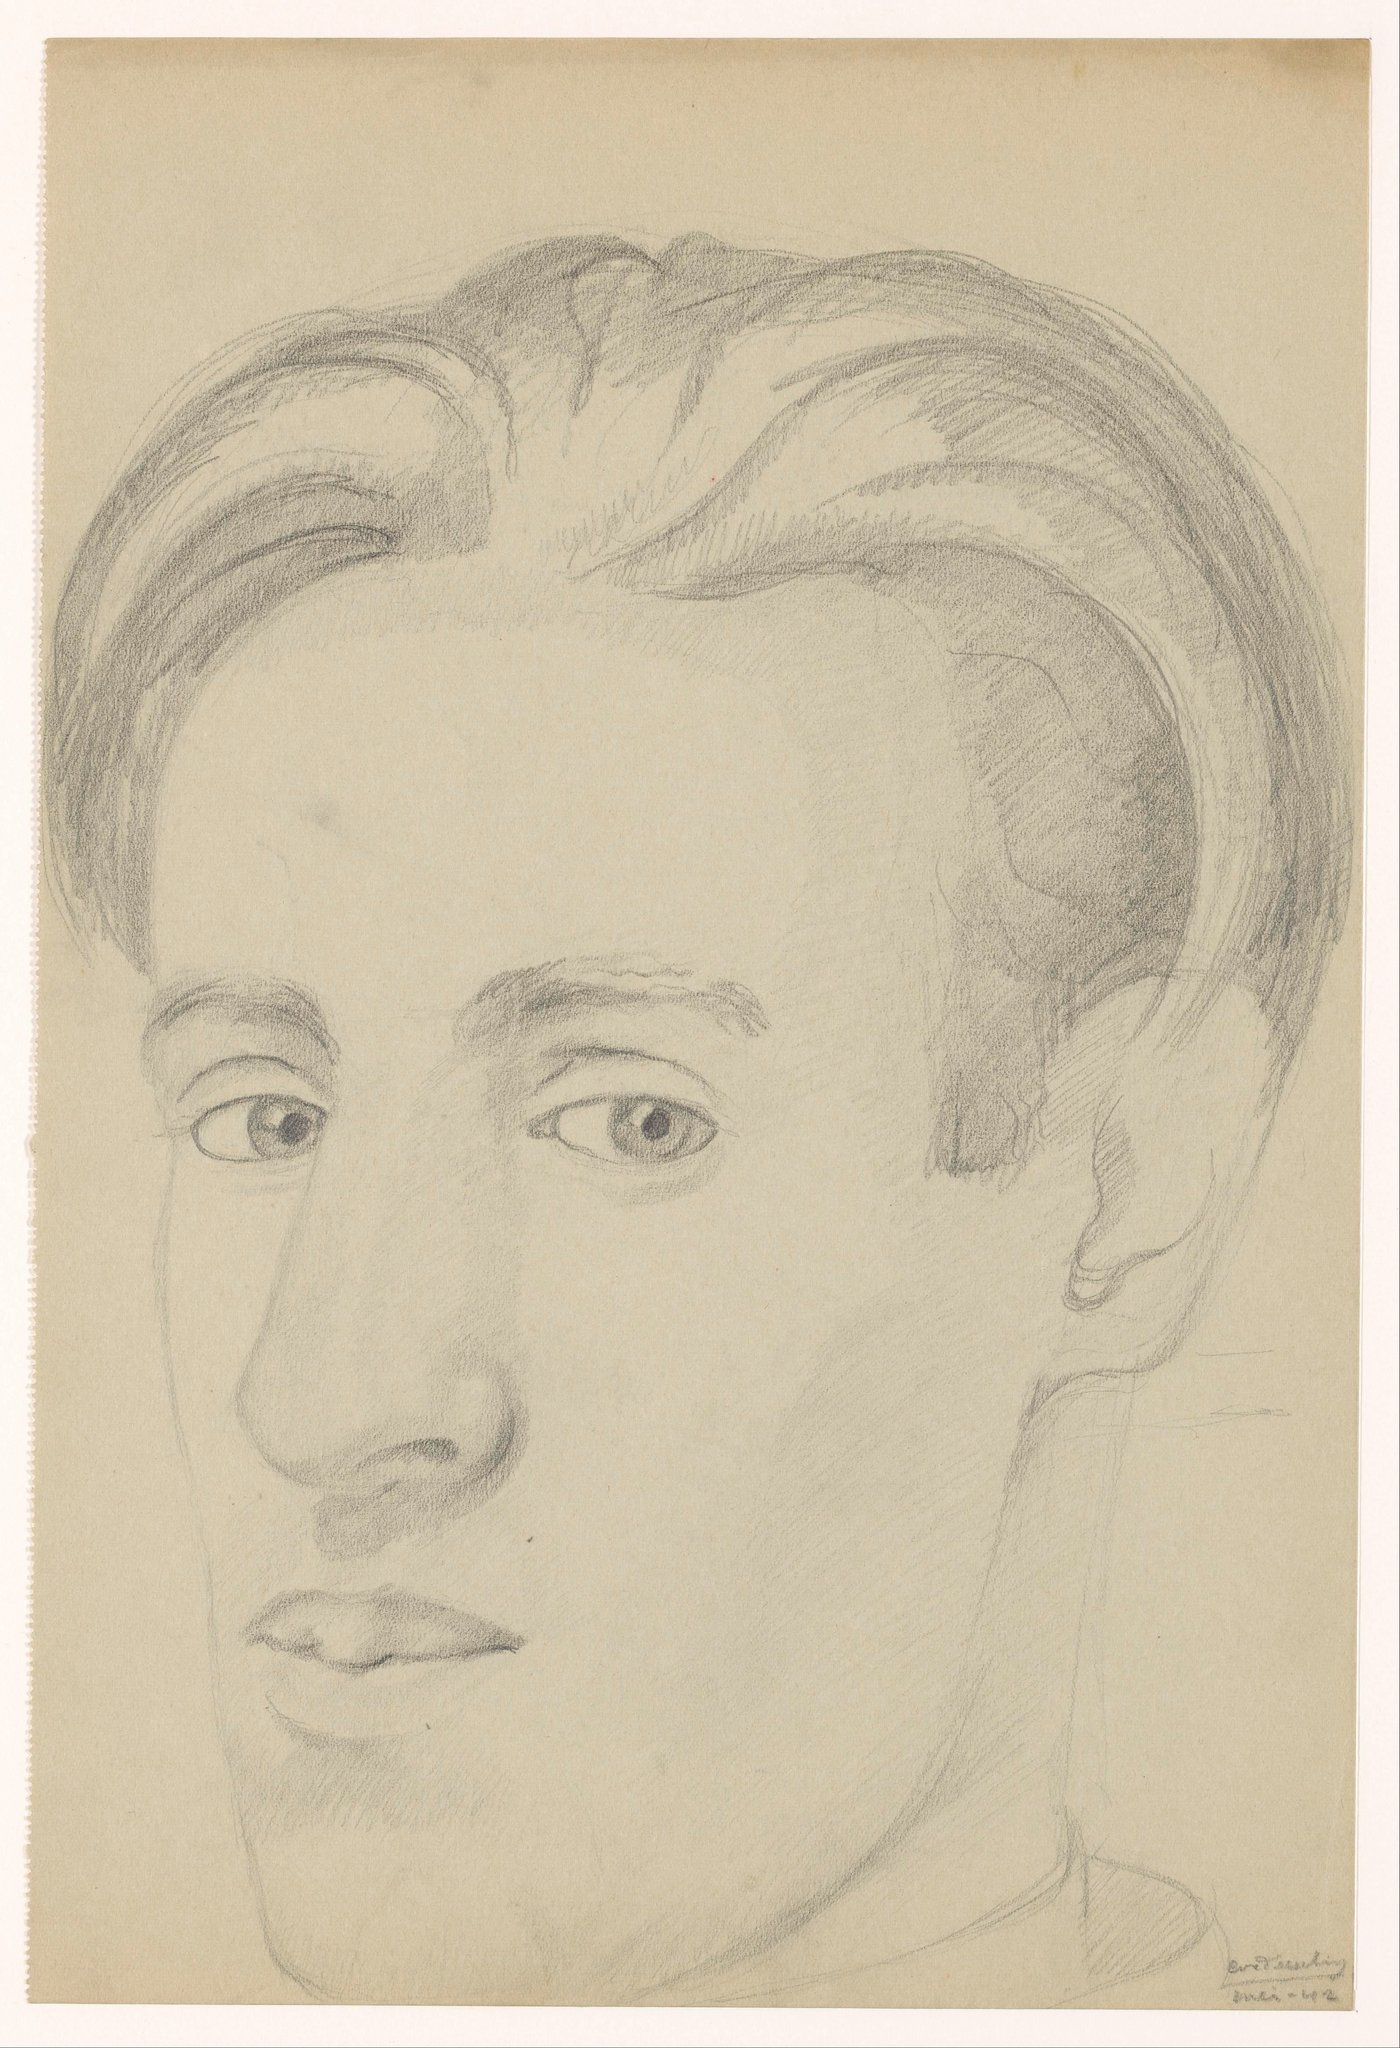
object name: drawing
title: Zelfportret, mei 1942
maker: cor van teeseling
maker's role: draughtsman, sculptor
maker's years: 1915-1942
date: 1905-1942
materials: paper, pencil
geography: amsterdam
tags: amsterdam, draughtsman, sculptor, cor van teeseling, historical persons, prisoner in cell or locked place, portrait, self-portrait of draughtsman, netherlands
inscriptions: inscription: ‘tot ziens’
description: Zelfportret van Cor van Teeseling, mei 1942. Cor van Teeseling driekwart afgebeeld, zijn hoofd naar links gewend.